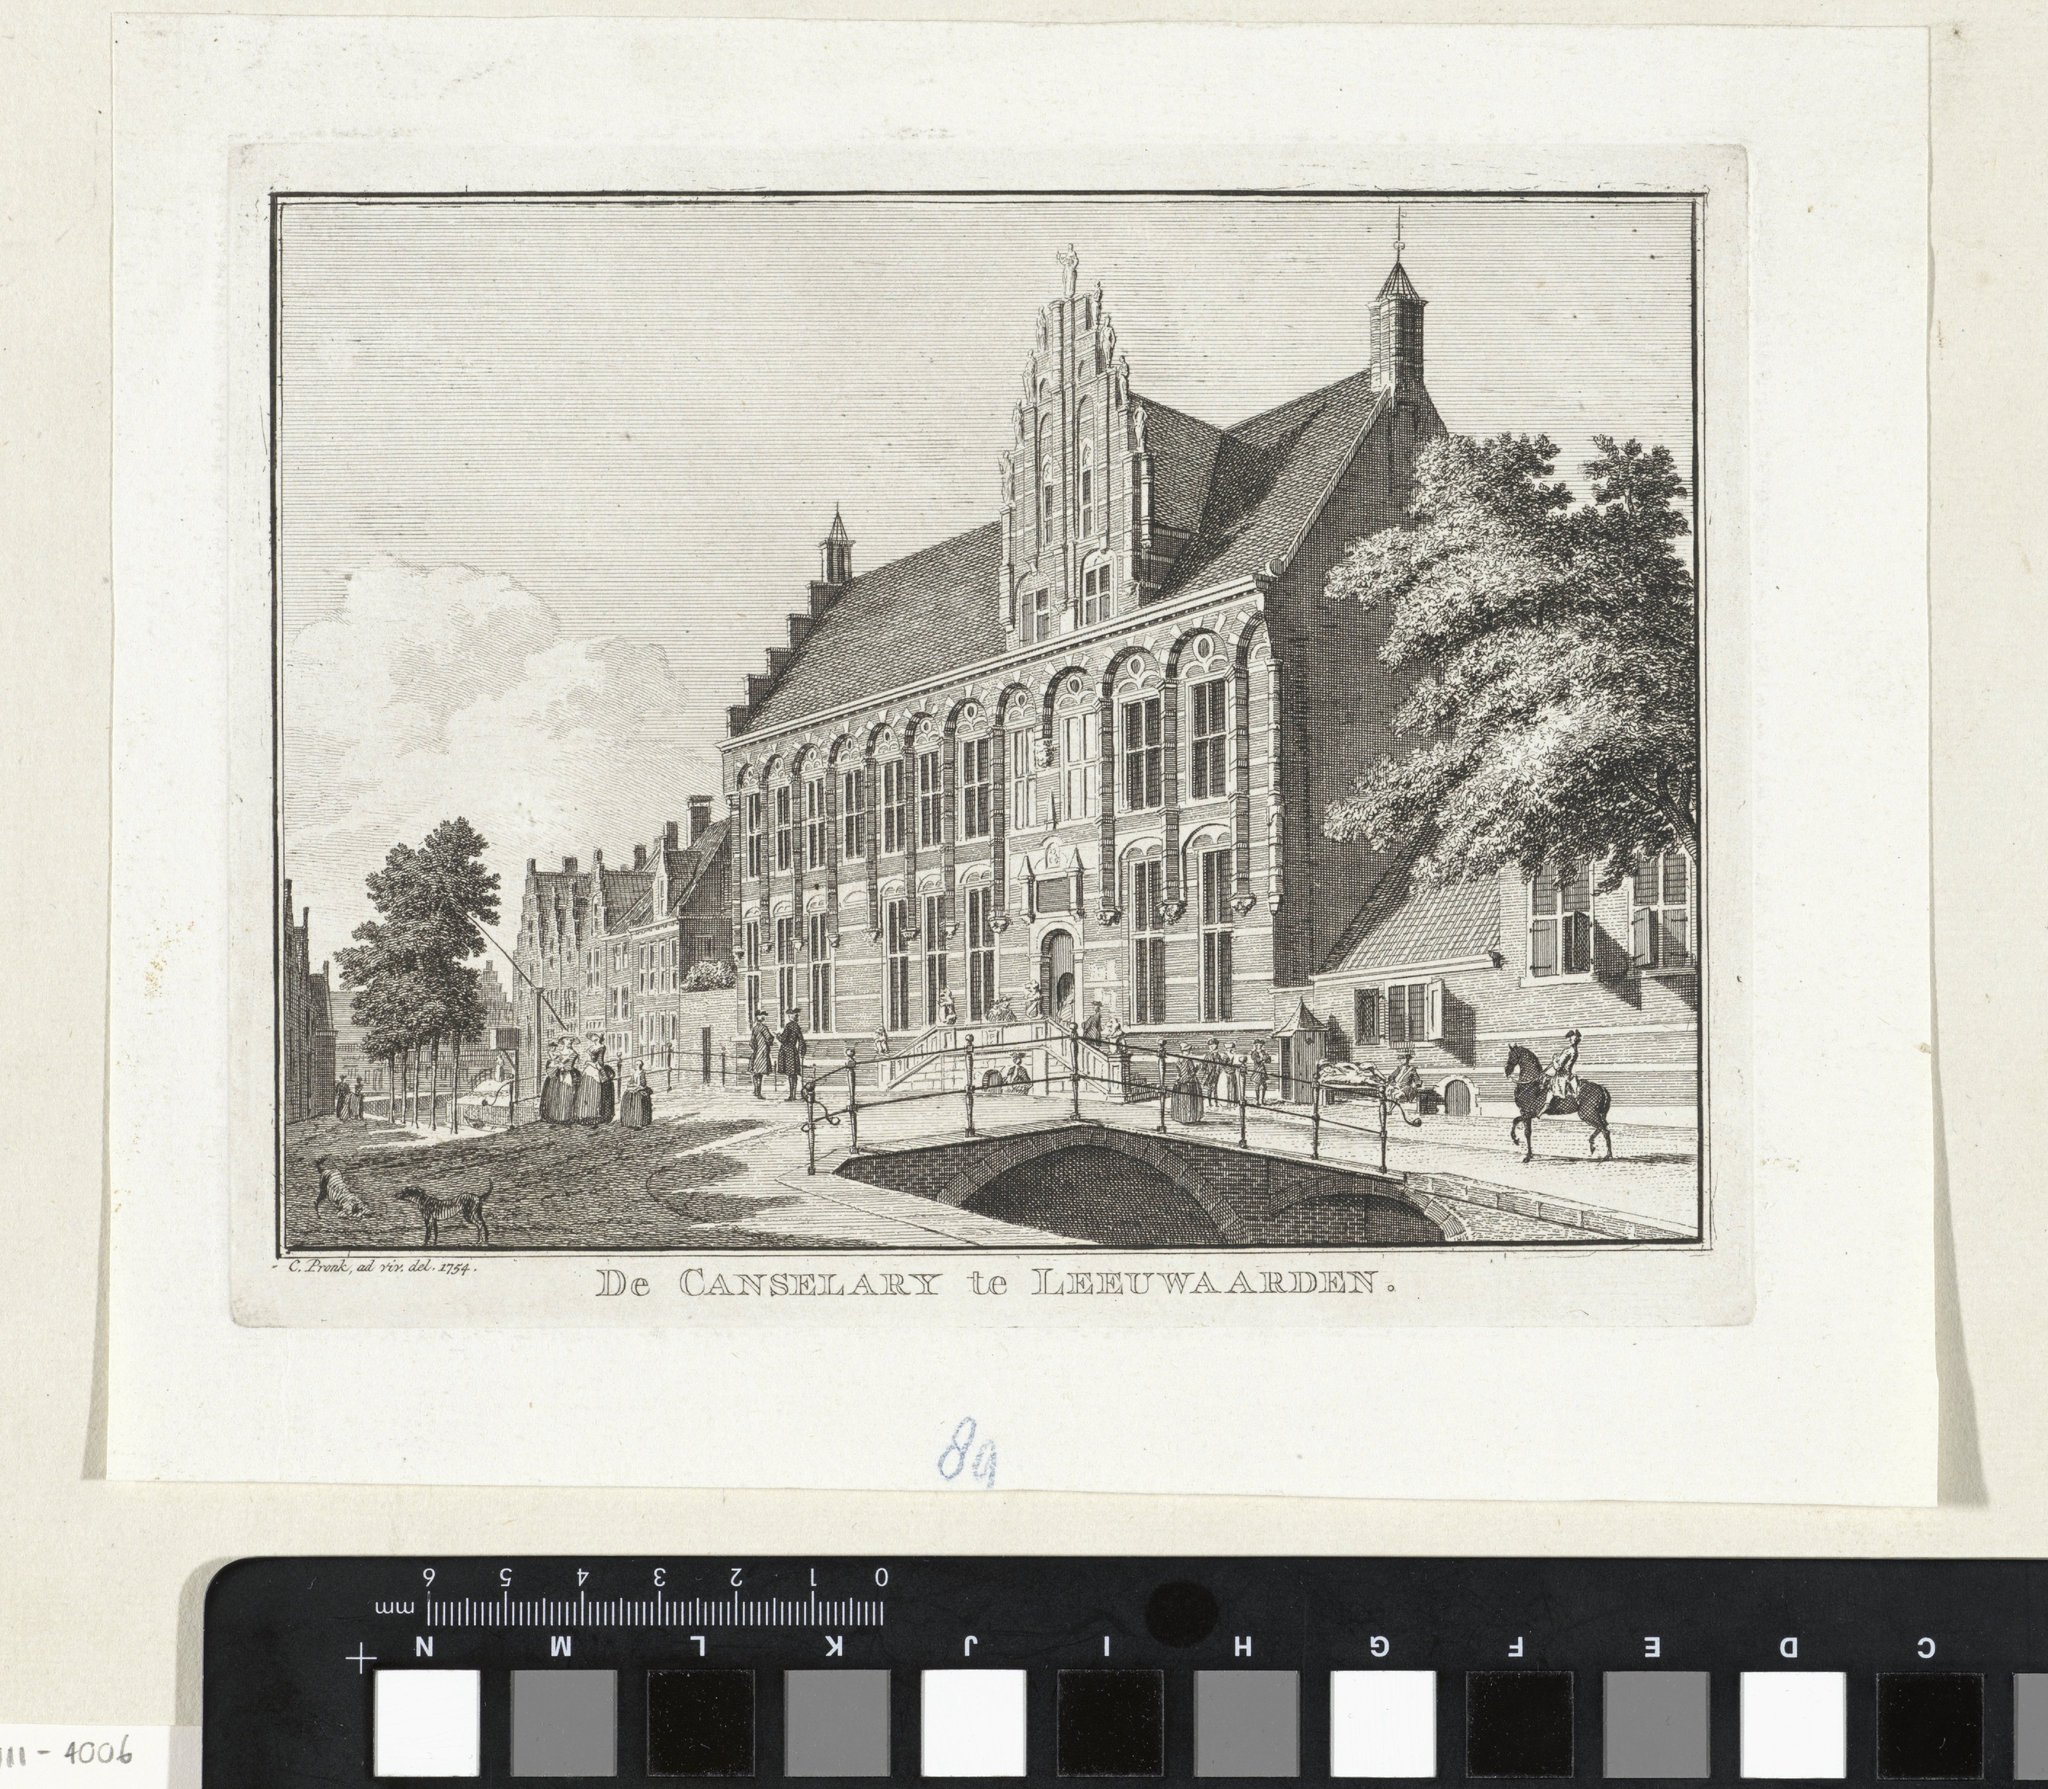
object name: print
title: Gezicht op de Kanselarij te Leewarden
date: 1754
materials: paper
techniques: etching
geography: low countries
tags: city-view, and landscape with man-made constructions (+ city(-scape) with figures, staffage)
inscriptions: collector's mark: Lugt 2228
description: Gezicht op de Kanselarij. Voor het gebouw en op de brug over de Turfmarkt enkele personen. Rechts een ruiter.